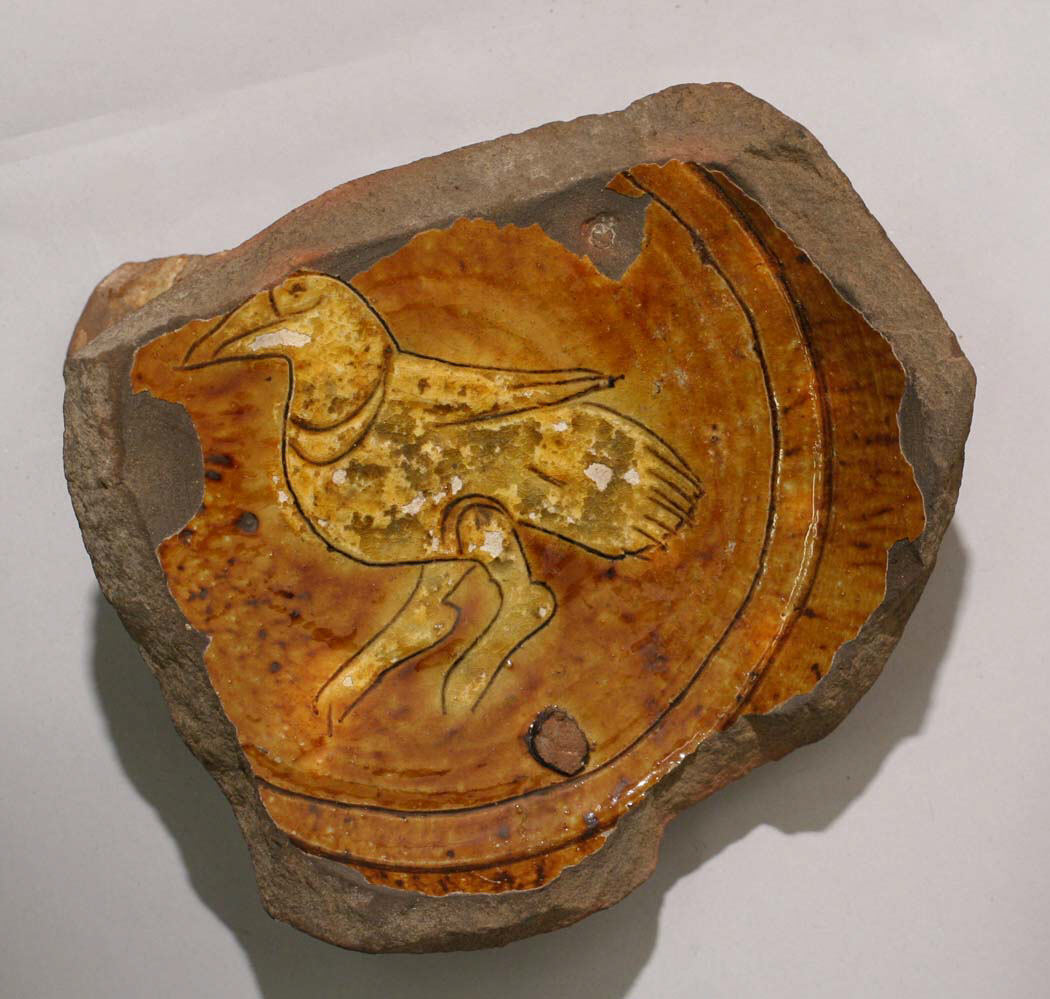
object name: fragment of a dish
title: Dish Fragment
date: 1301-1500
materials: earthenware, glaze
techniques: coloring, incising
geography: egypt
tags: birds